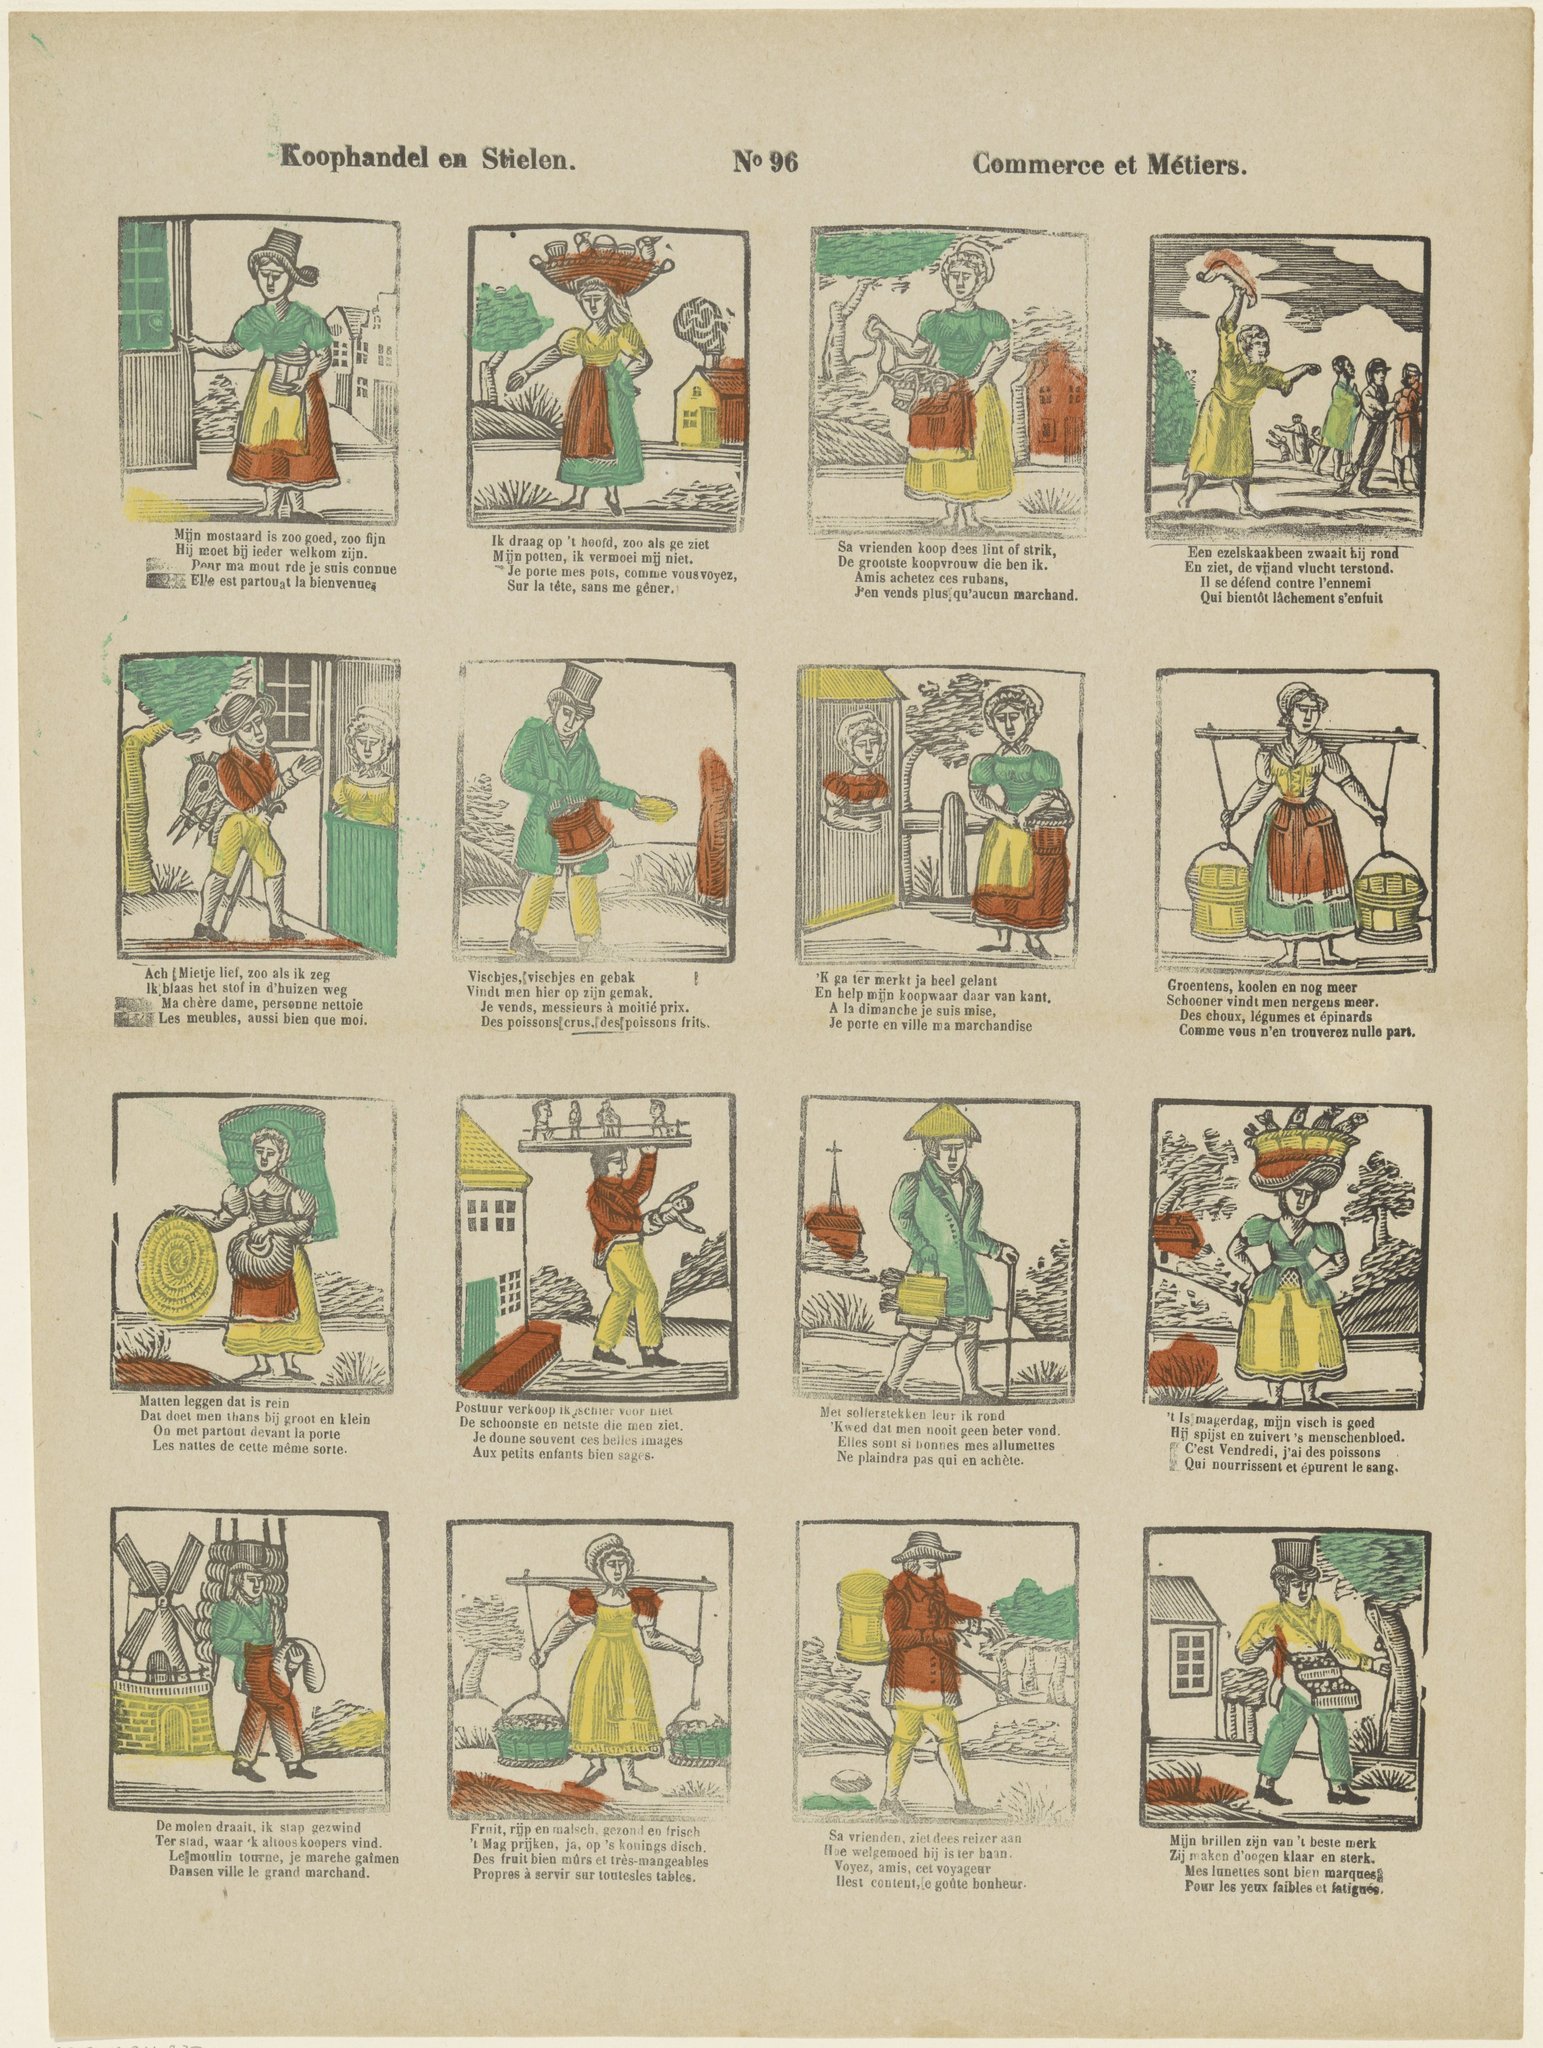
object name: popular print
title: Koophandel en stielen / Commerce et métiers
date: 1866-1902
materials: paper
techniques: colour, letterpress printing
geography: turnhout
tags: street-trader, crafts and industries, merchant, salesman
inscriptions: collector's mark: Lugt 2760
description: Blad met 16 voorstellingen van straatverkopers, zoals een pottenverkoopster, een verkoper van gebakken vis en een brillenverkoper. Onder elke afbeelding een tweeregelig vers in het Nederlands en in het Frans. Genummerd midden boven: No 96.